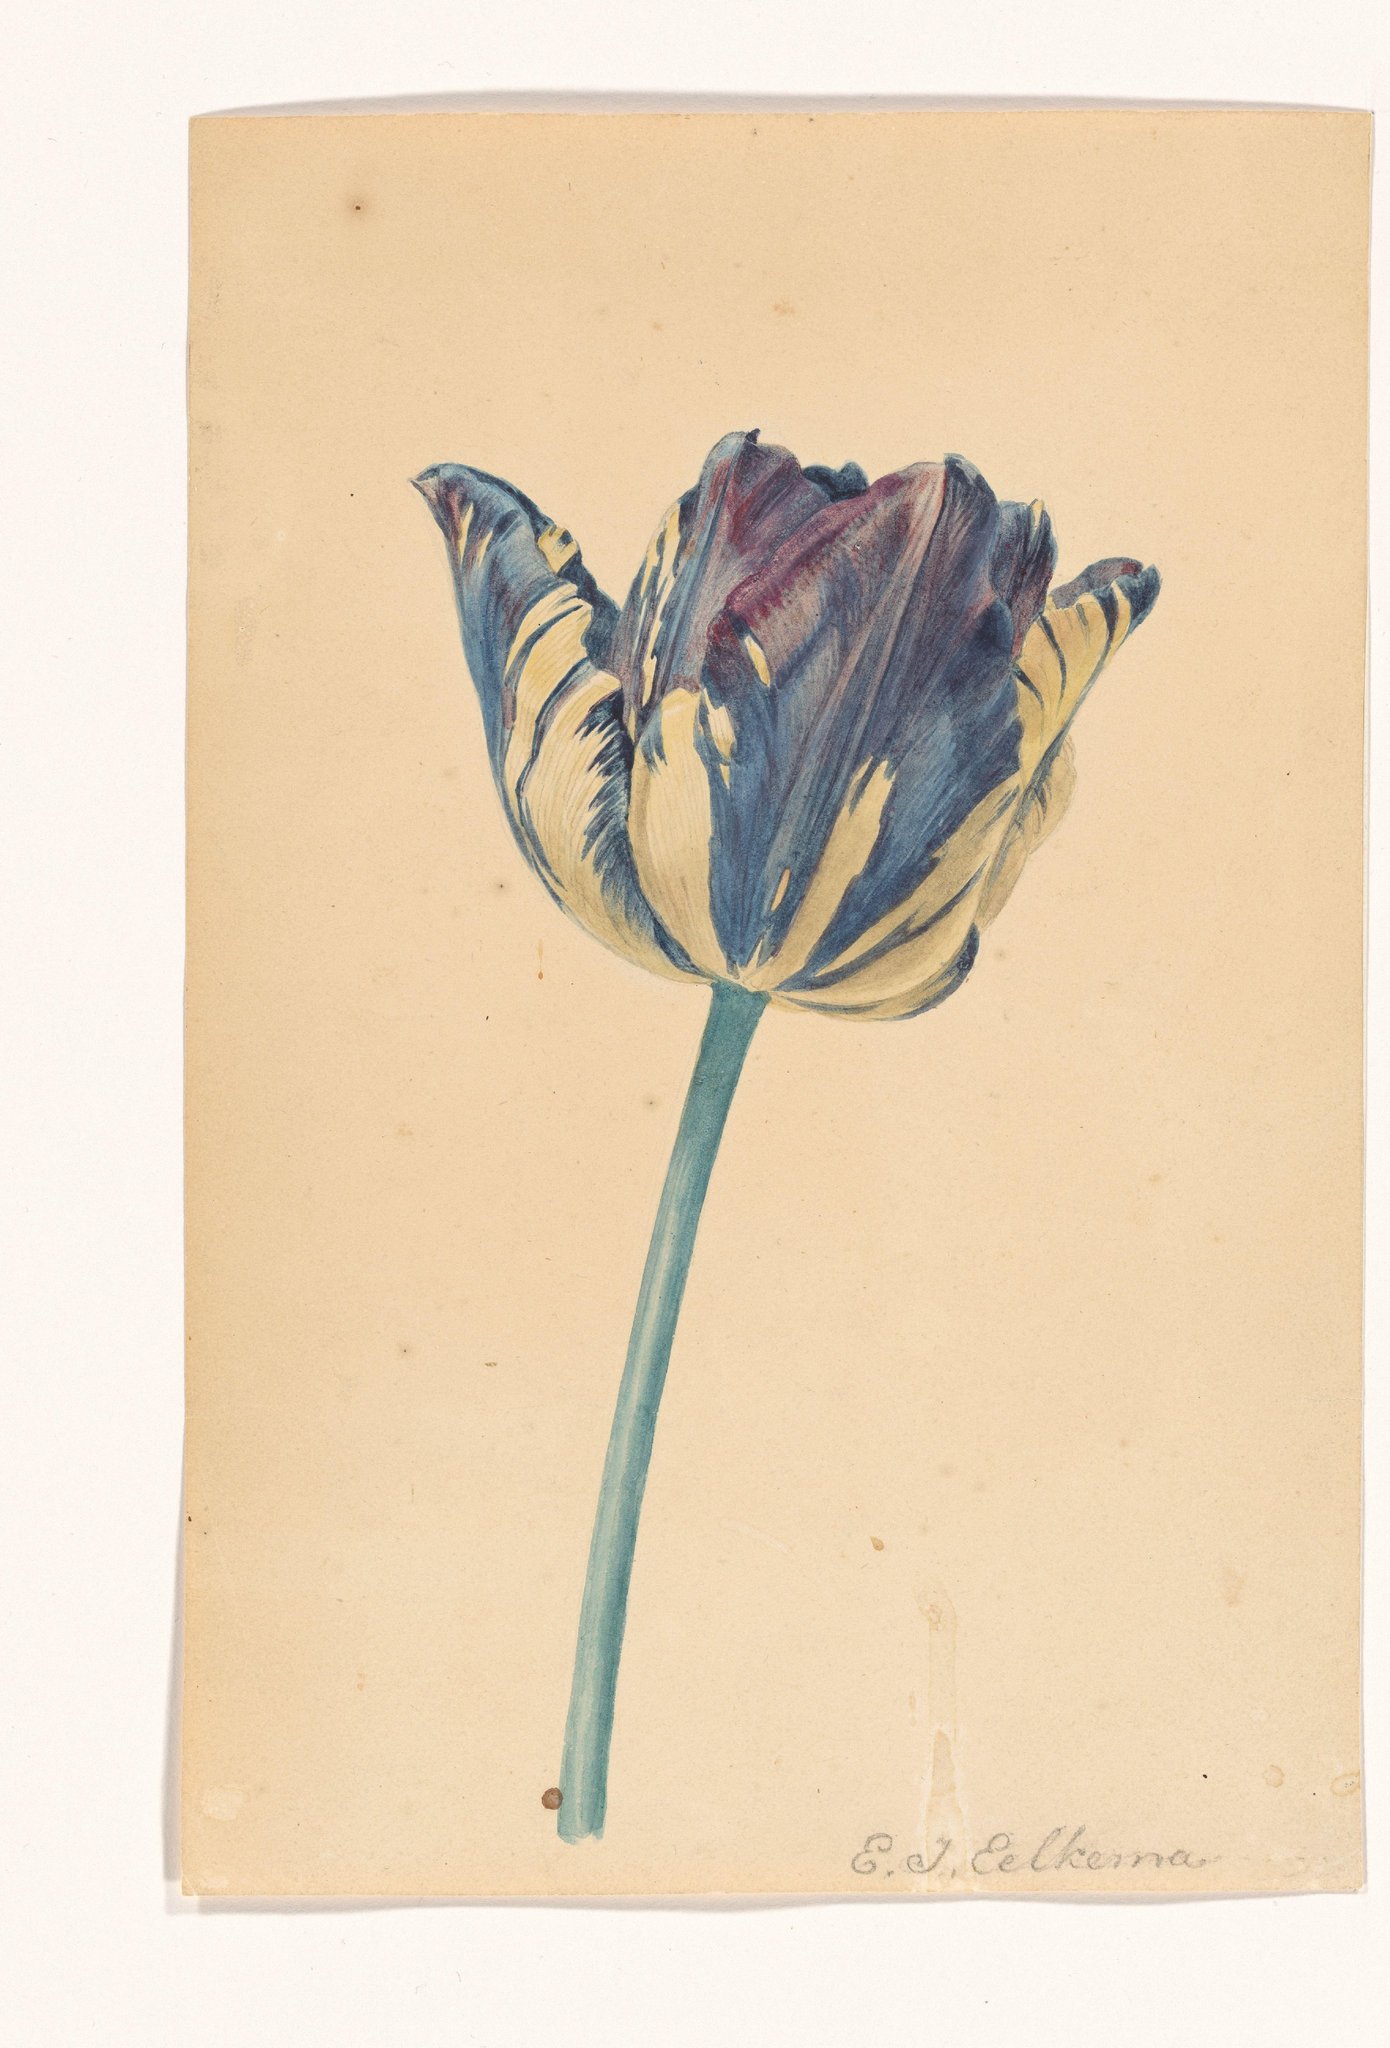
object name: drawing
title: Tulp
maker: eelke jelles eelkema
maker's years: 1788-1839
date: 1815-1830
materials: paper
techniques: drawing